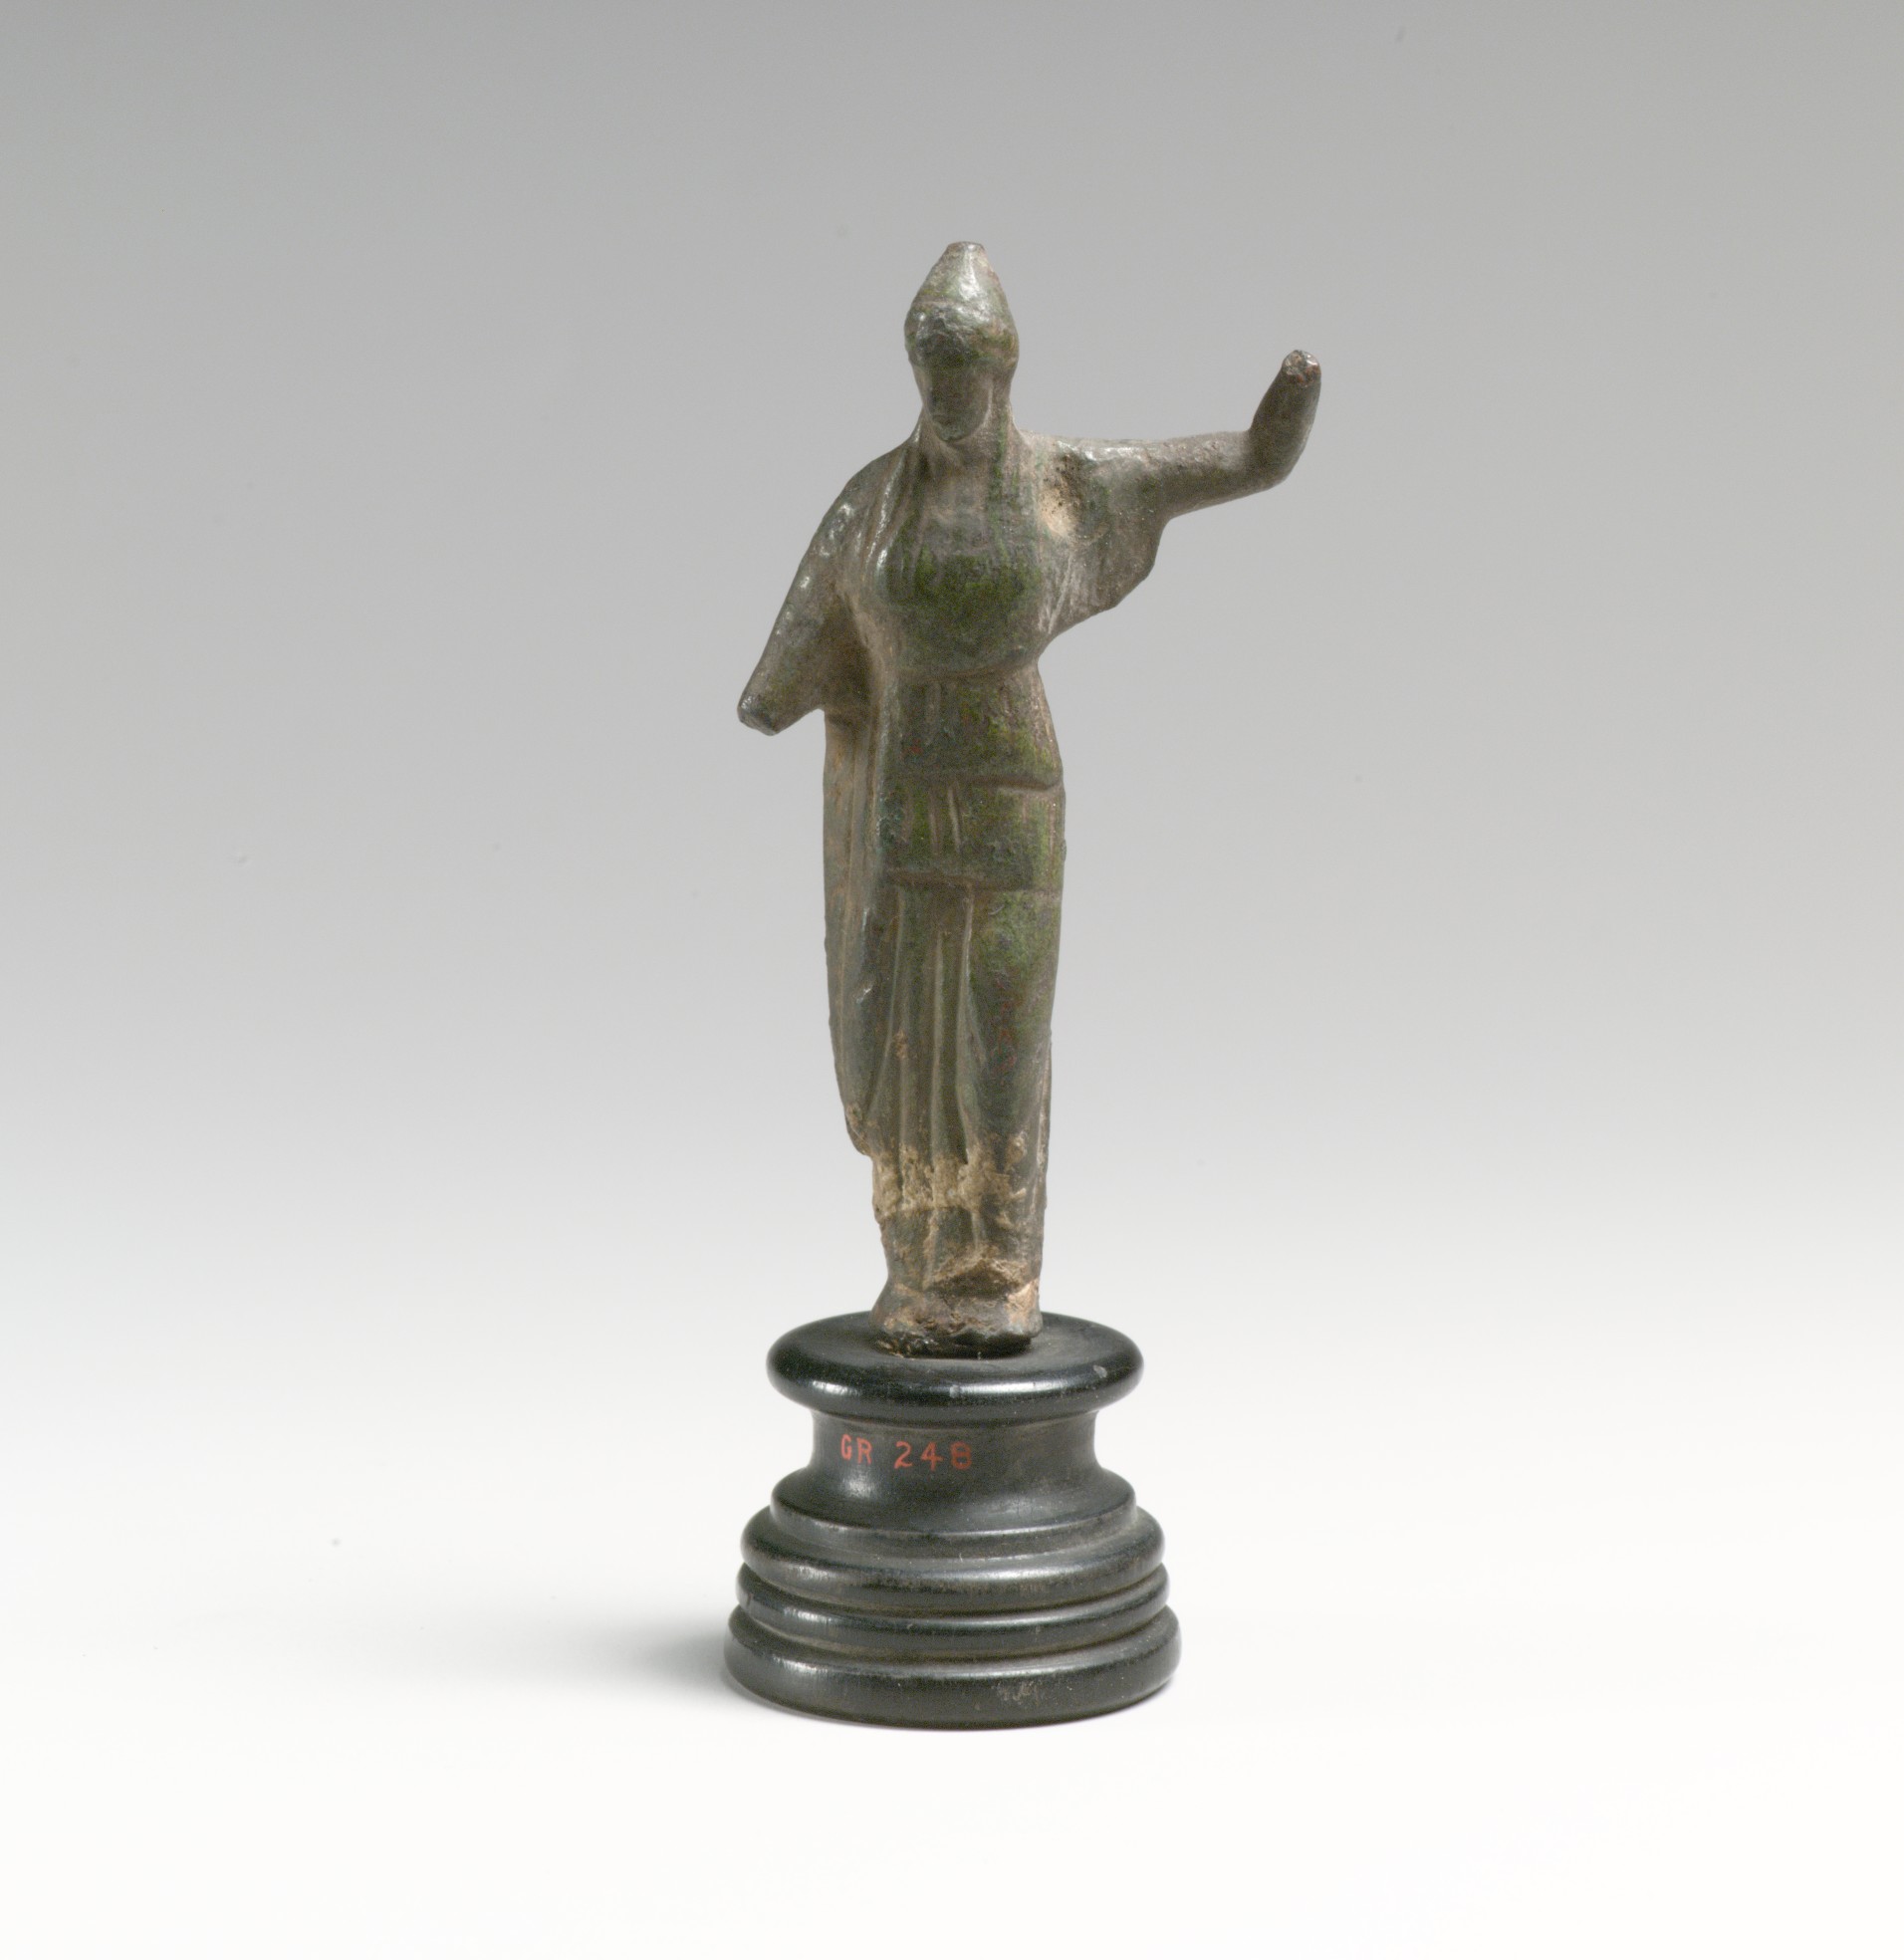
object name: statuette of a woman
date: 7000 BCE-330 CE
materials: bronze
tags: women